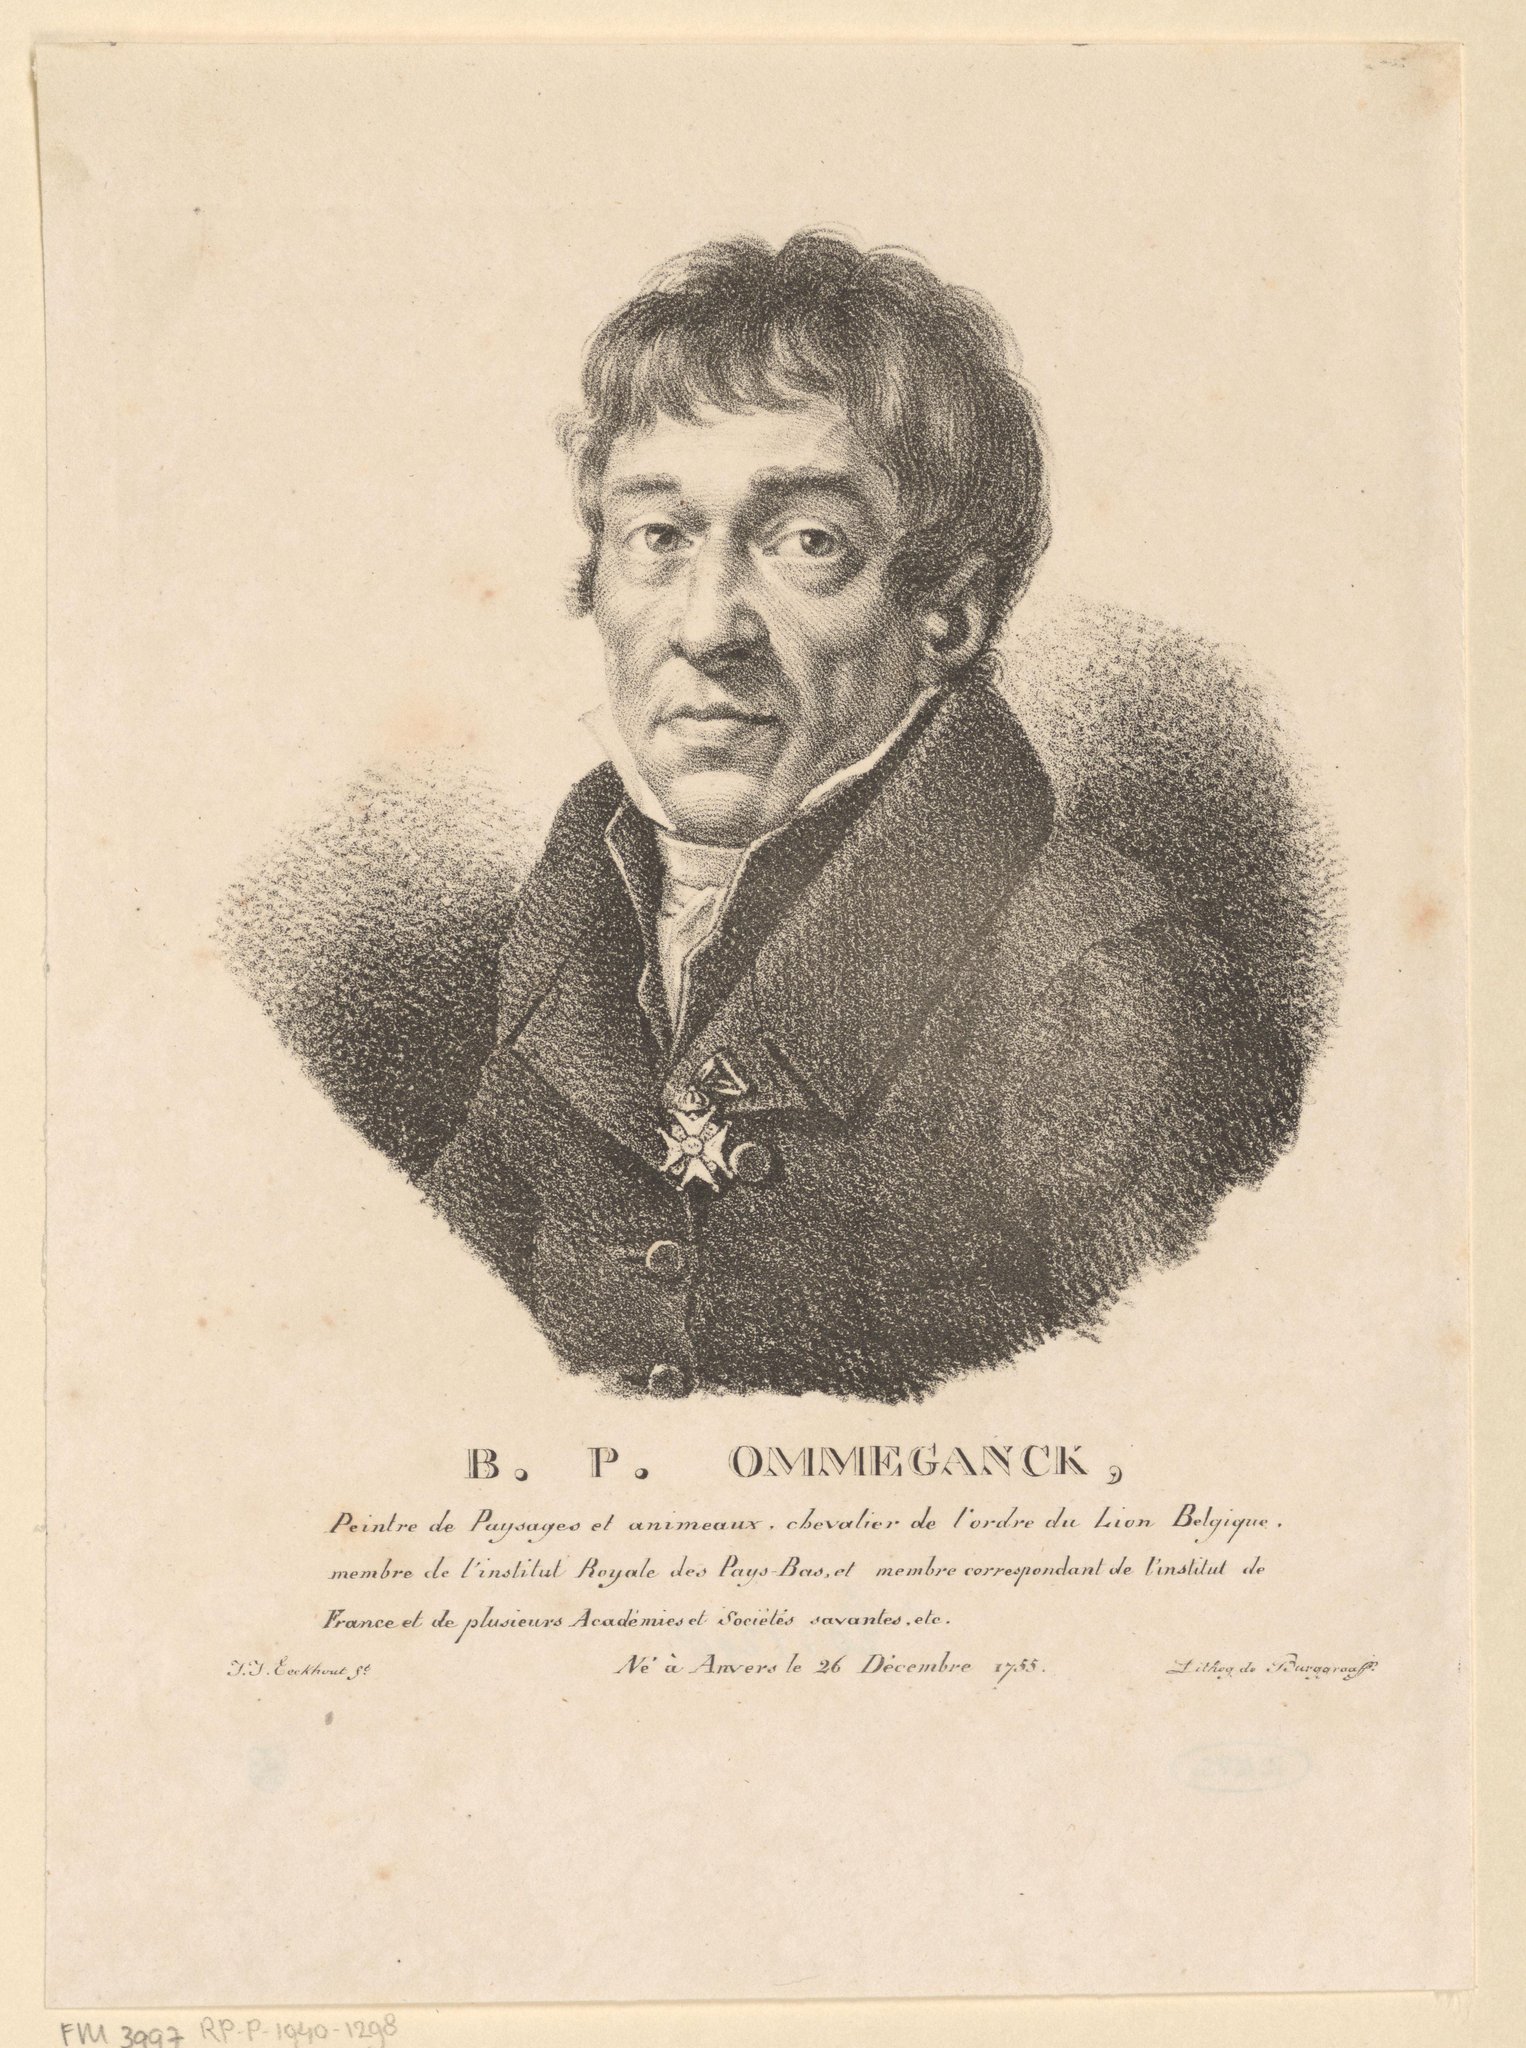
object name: print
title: Portretten van hedendaagse kunstenaars uit het Verenigd Koninkrijk der Nederlanden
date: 1822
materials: paper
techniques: lithograph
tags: antwerp, painter, print maker, draughtsman, balthasar paul ommeganck, historical persons, portrait, self-portrait of painter, medals and other marks of military honour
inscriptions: collector's mark: Lugt 2228, collector's mark: Lugt 2760